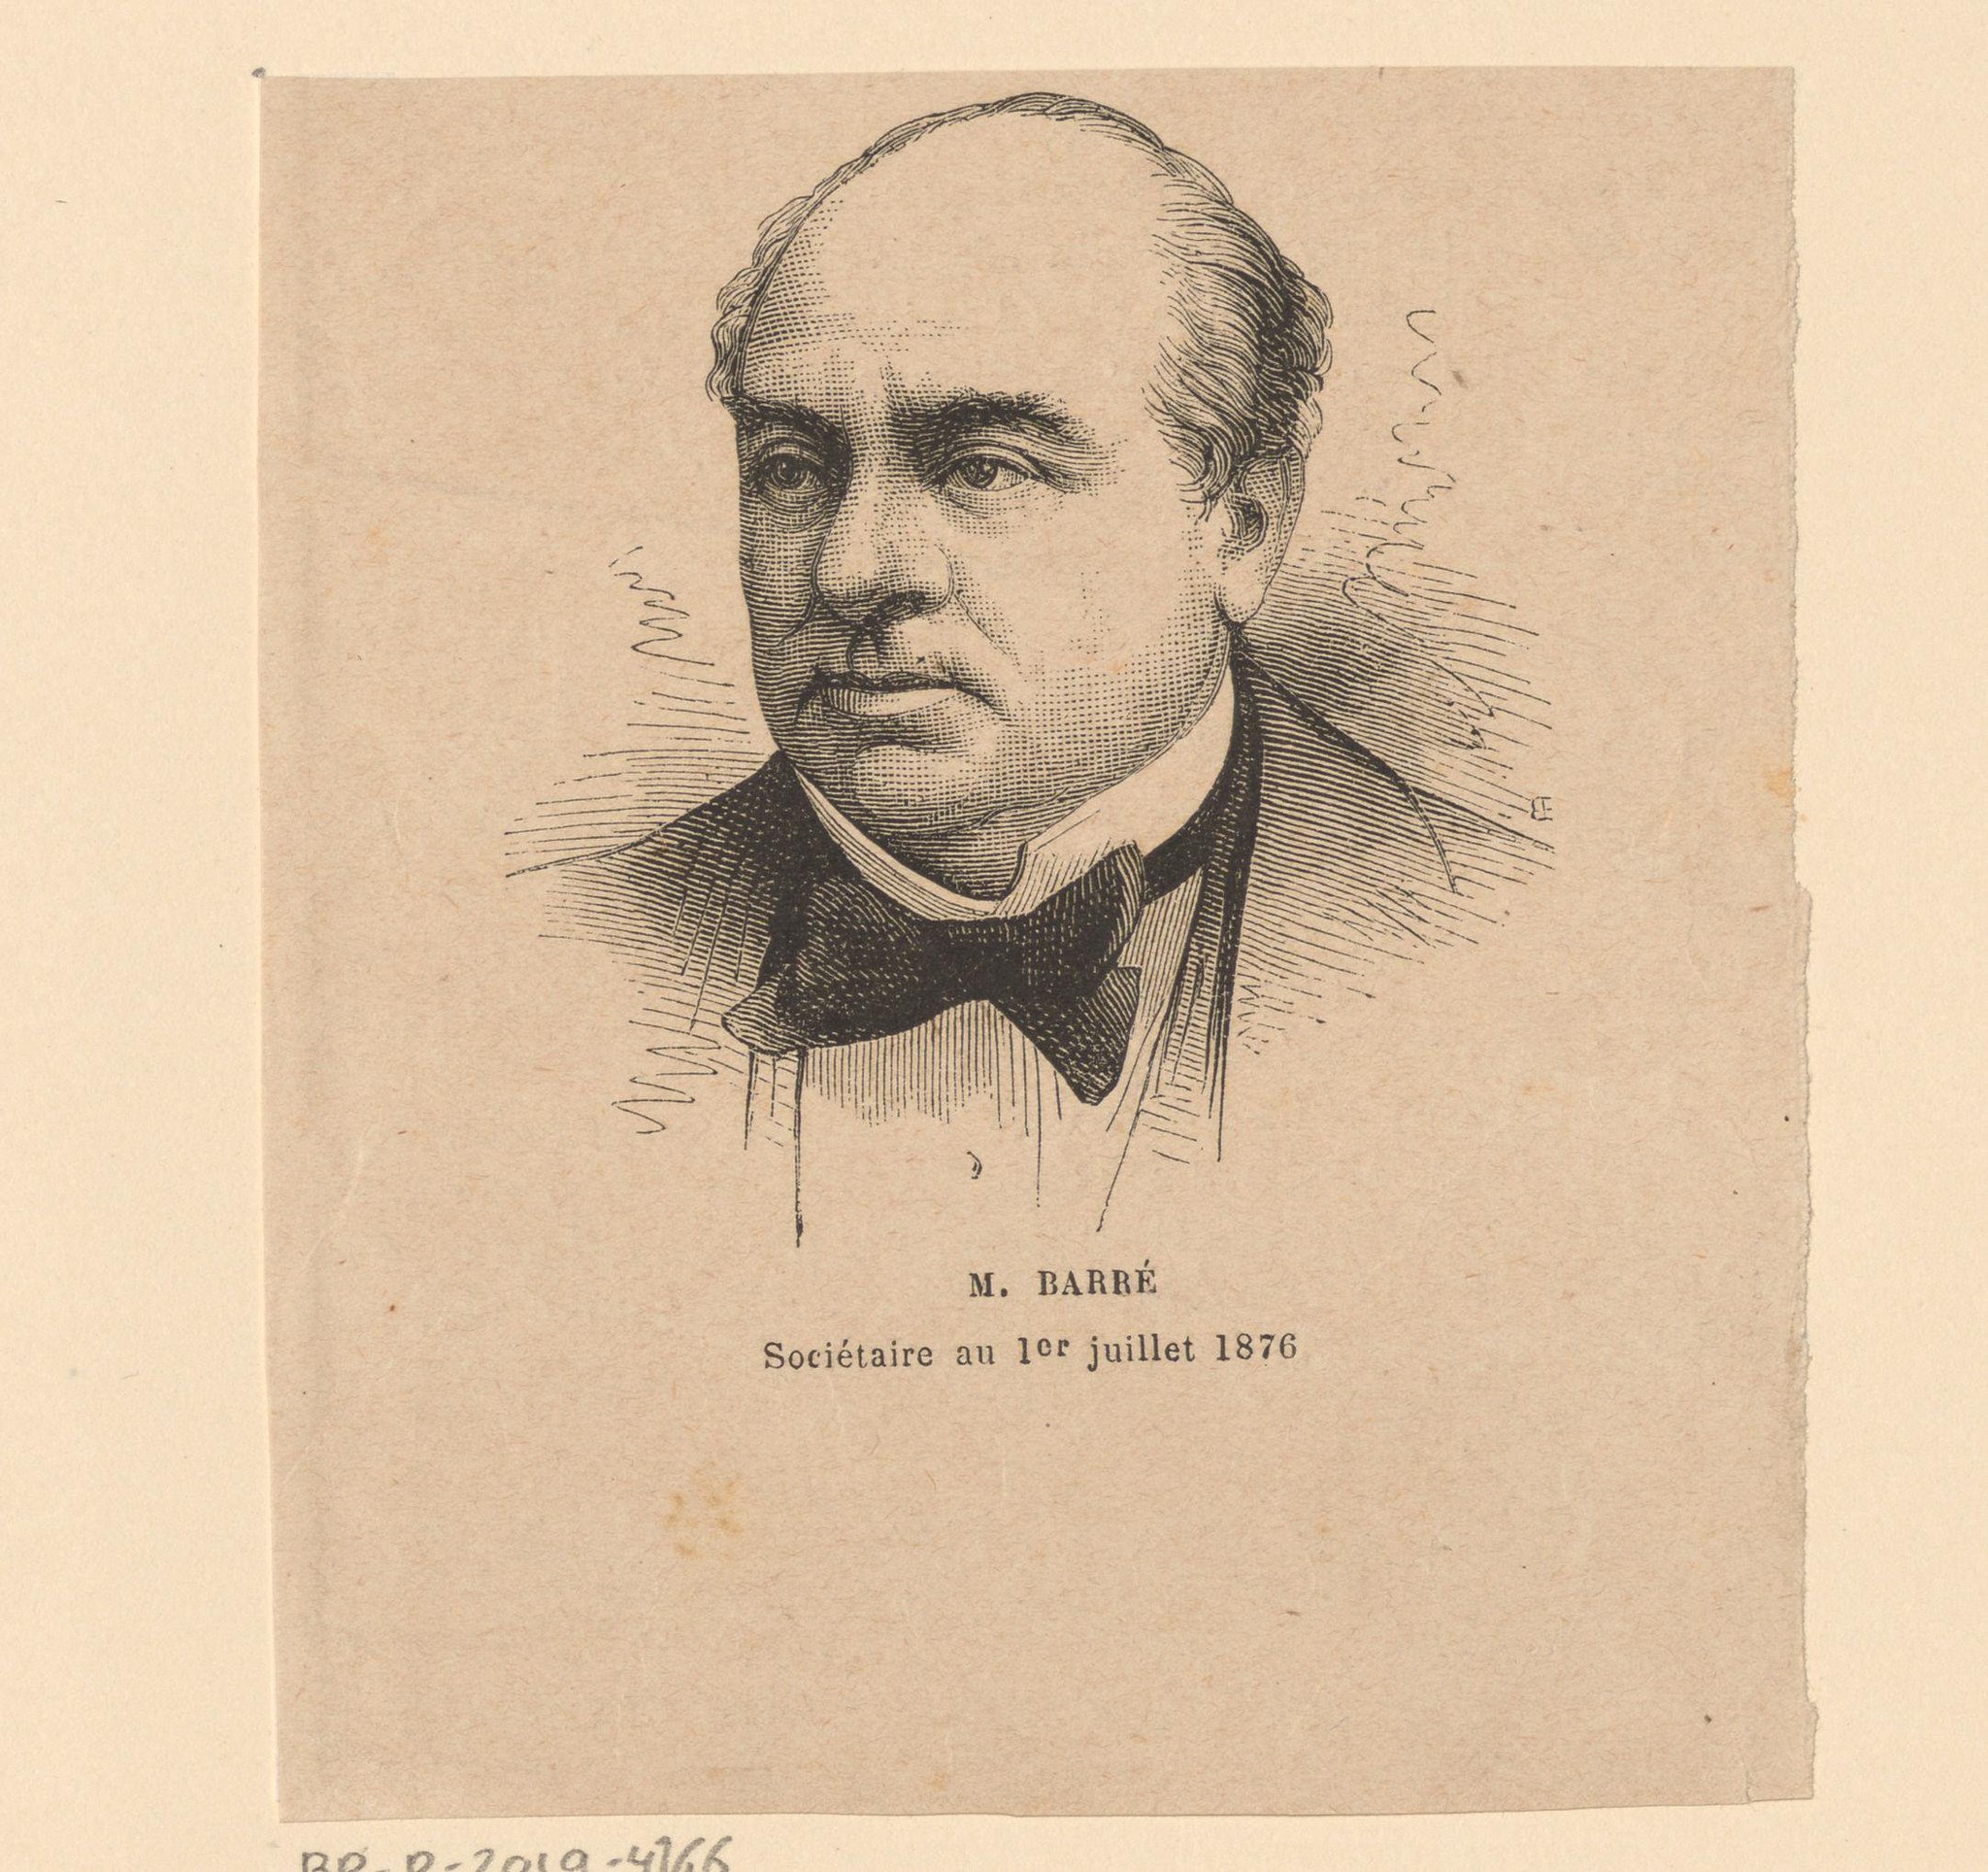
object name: book illustration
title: Portret van Léopold Barré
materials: paper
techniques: letterpress printing, engraving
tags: historical persons